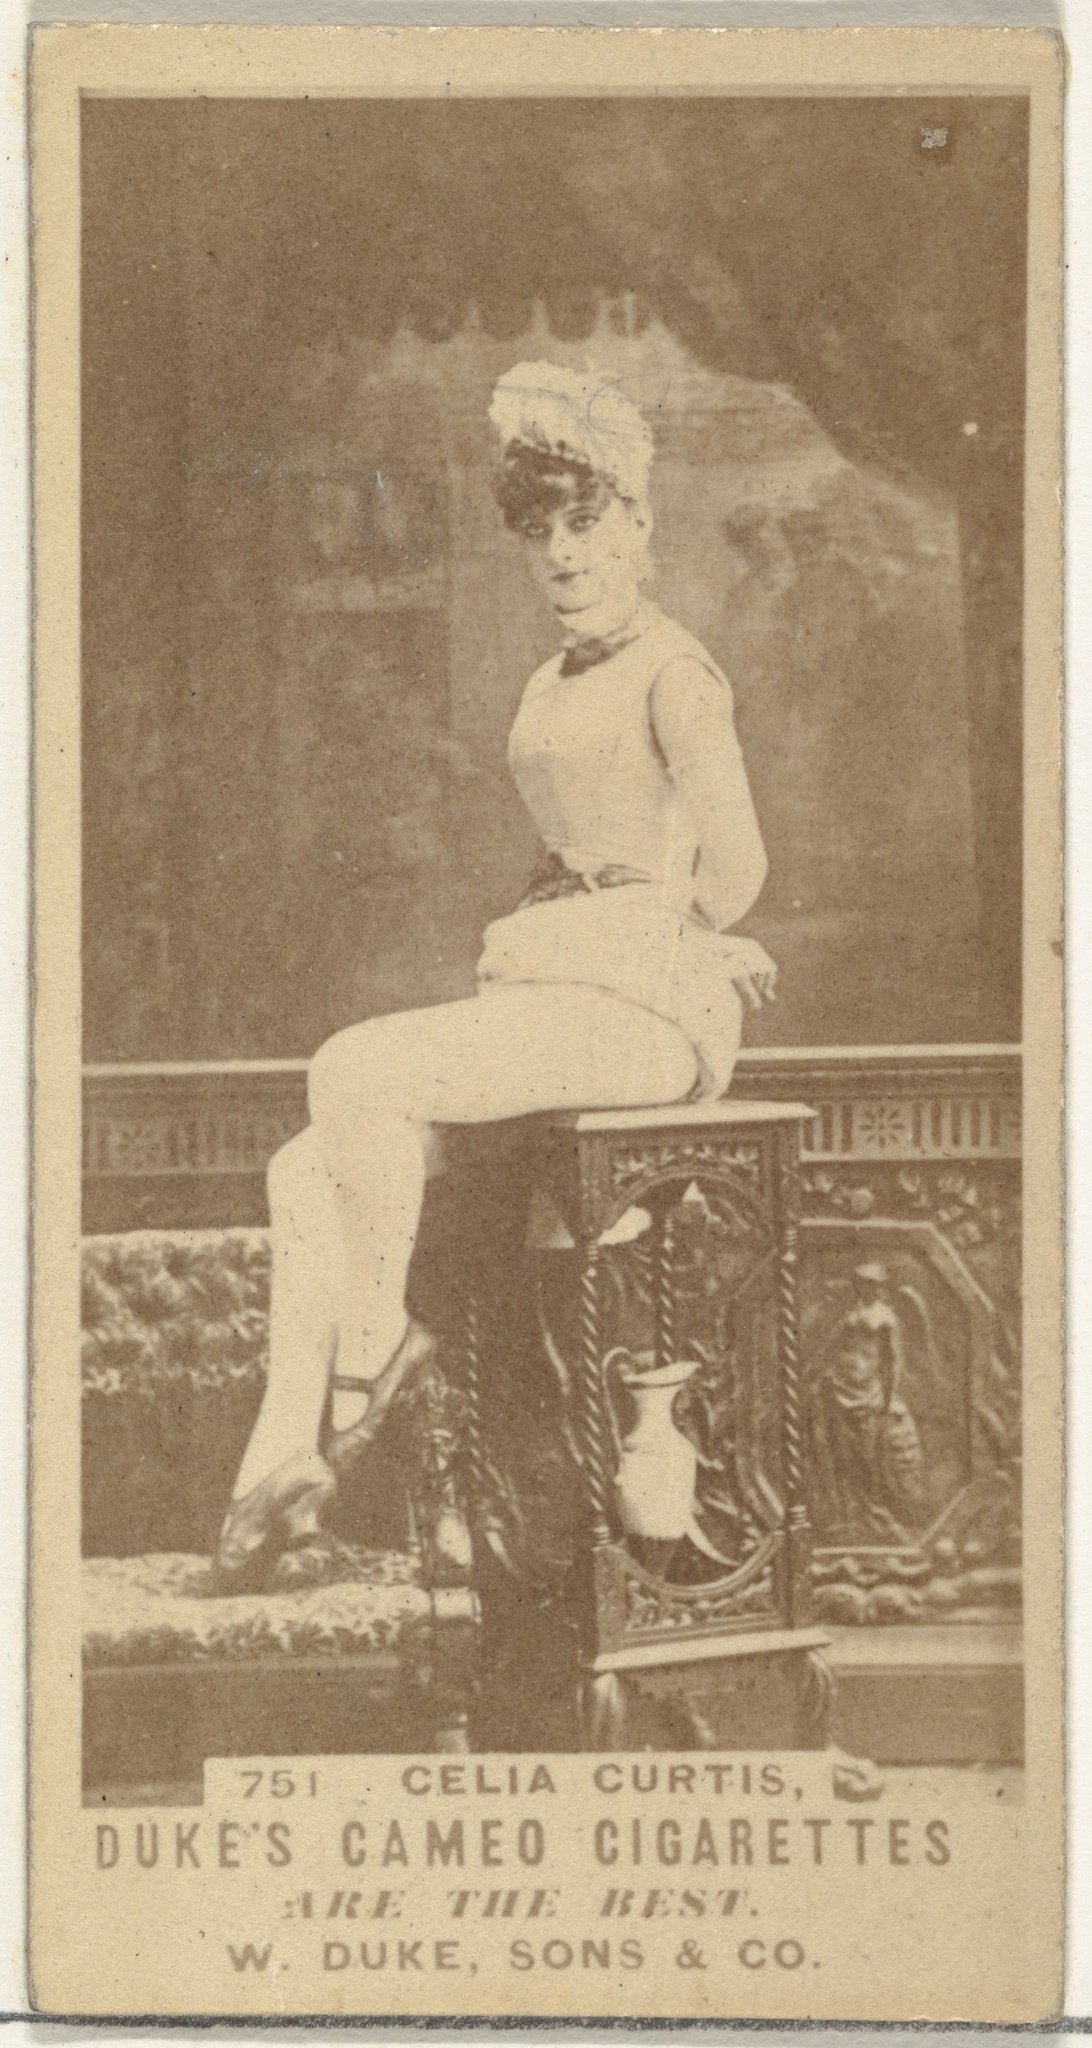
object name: photograph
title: Card Number 751, Celia Curtis, from the Actors and Actresses series (N145-5) issued by Duke Sons & Co. to promote Cameo Cigarettes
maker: w. duke, sons & co.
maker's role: publisher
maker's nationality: american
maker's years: 1870-1920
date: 1880-1889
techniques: albumen silver print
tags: portraits,women,actresses